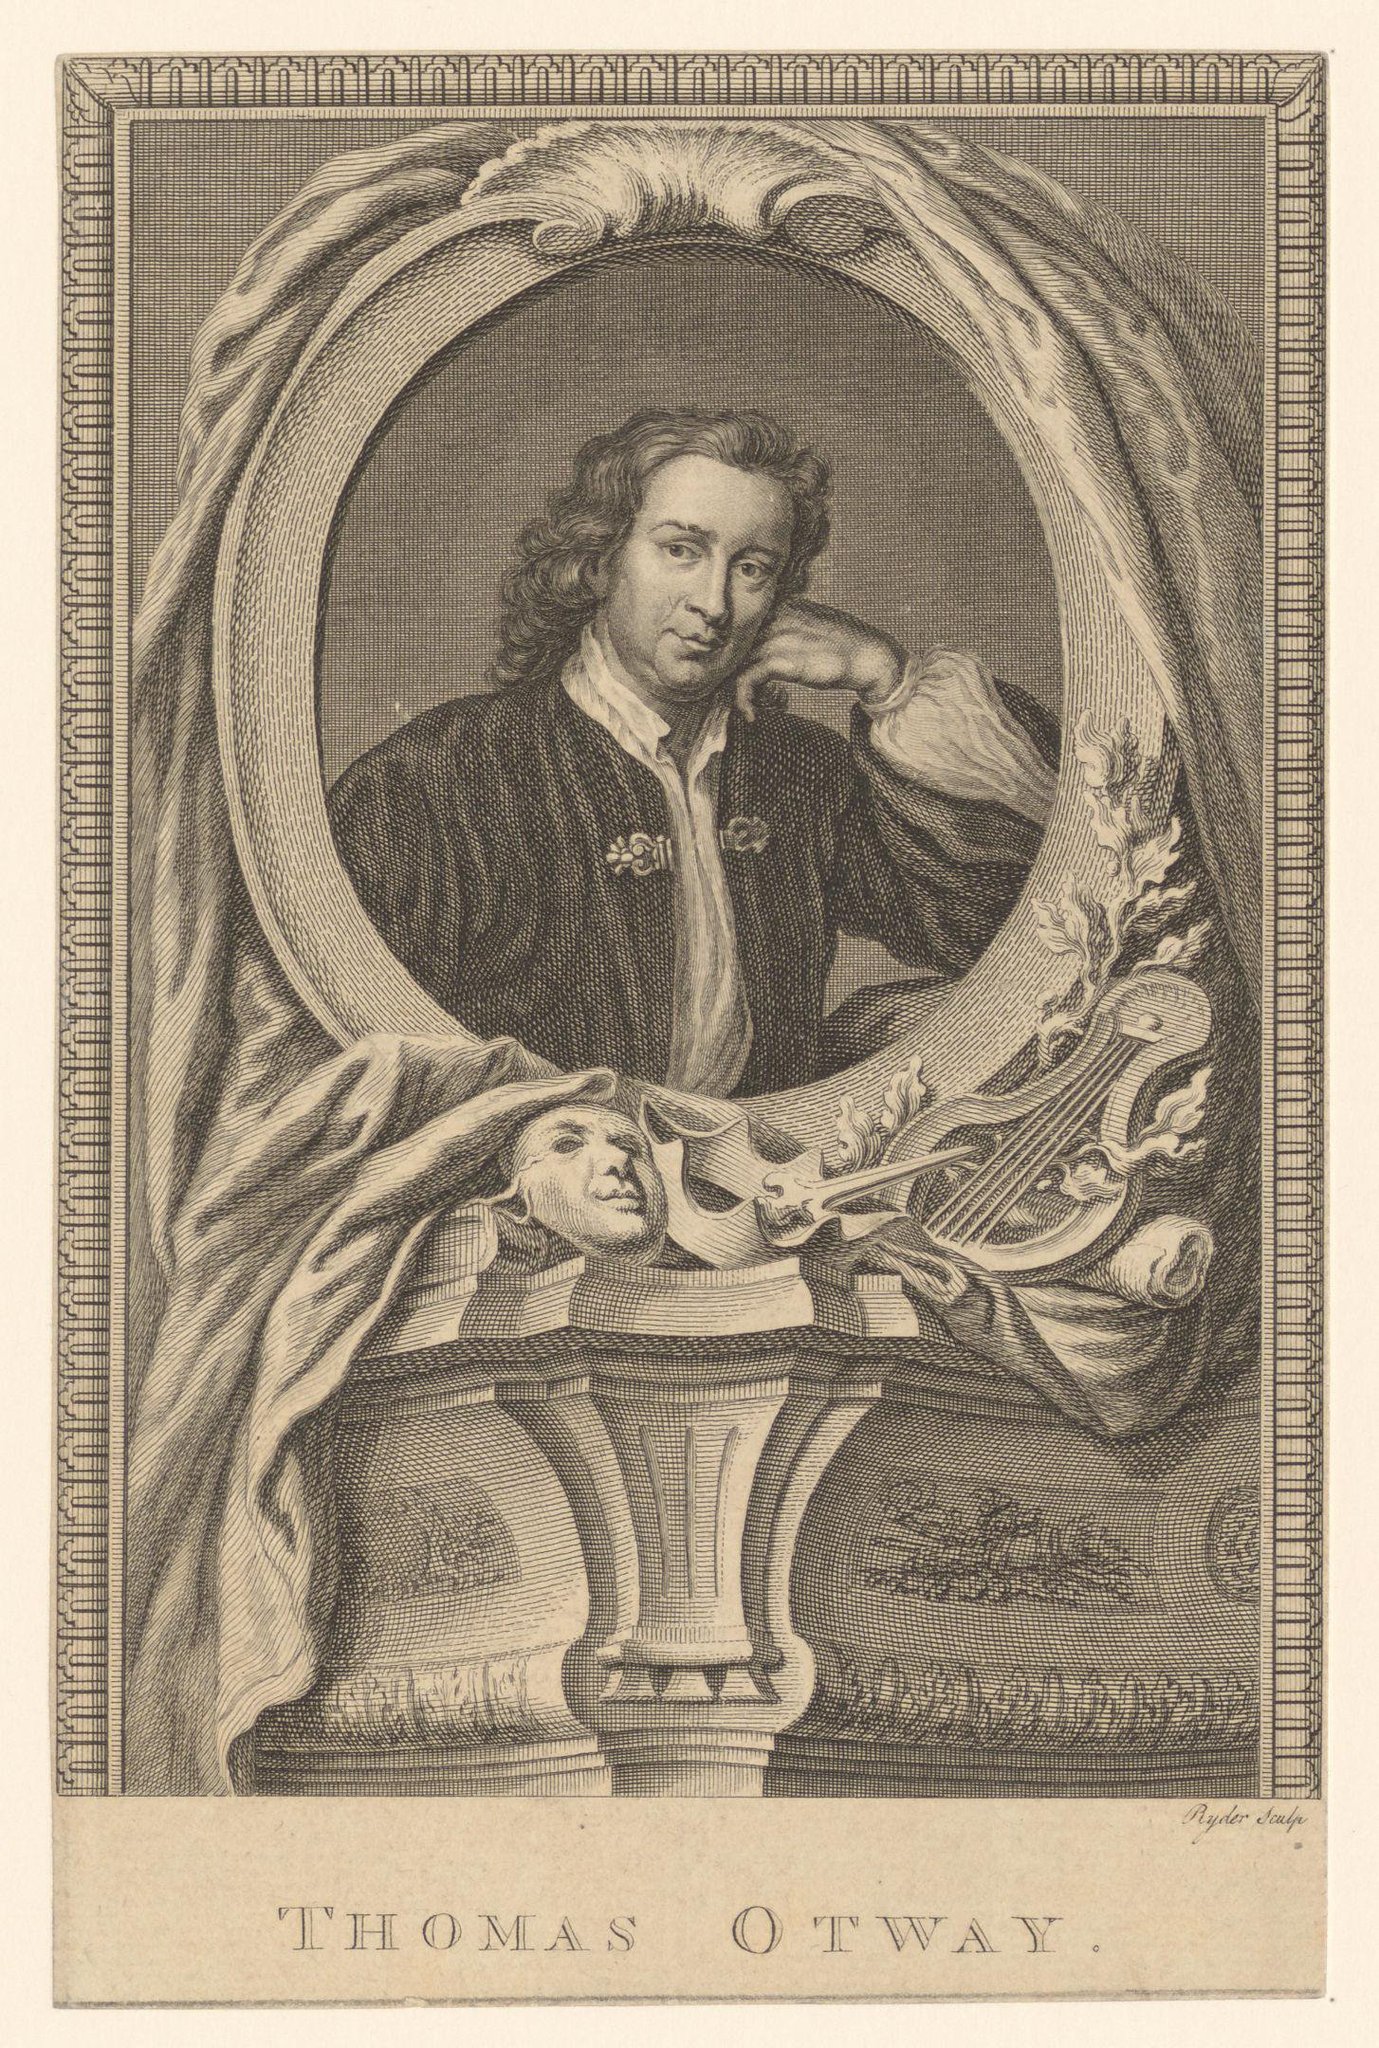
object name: print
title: Portret van Thomas Otway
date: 1776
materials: paper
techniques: engraving, etching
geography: london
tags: historical persons, portrait of a writer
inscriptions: collector's mark: Lugt 2228